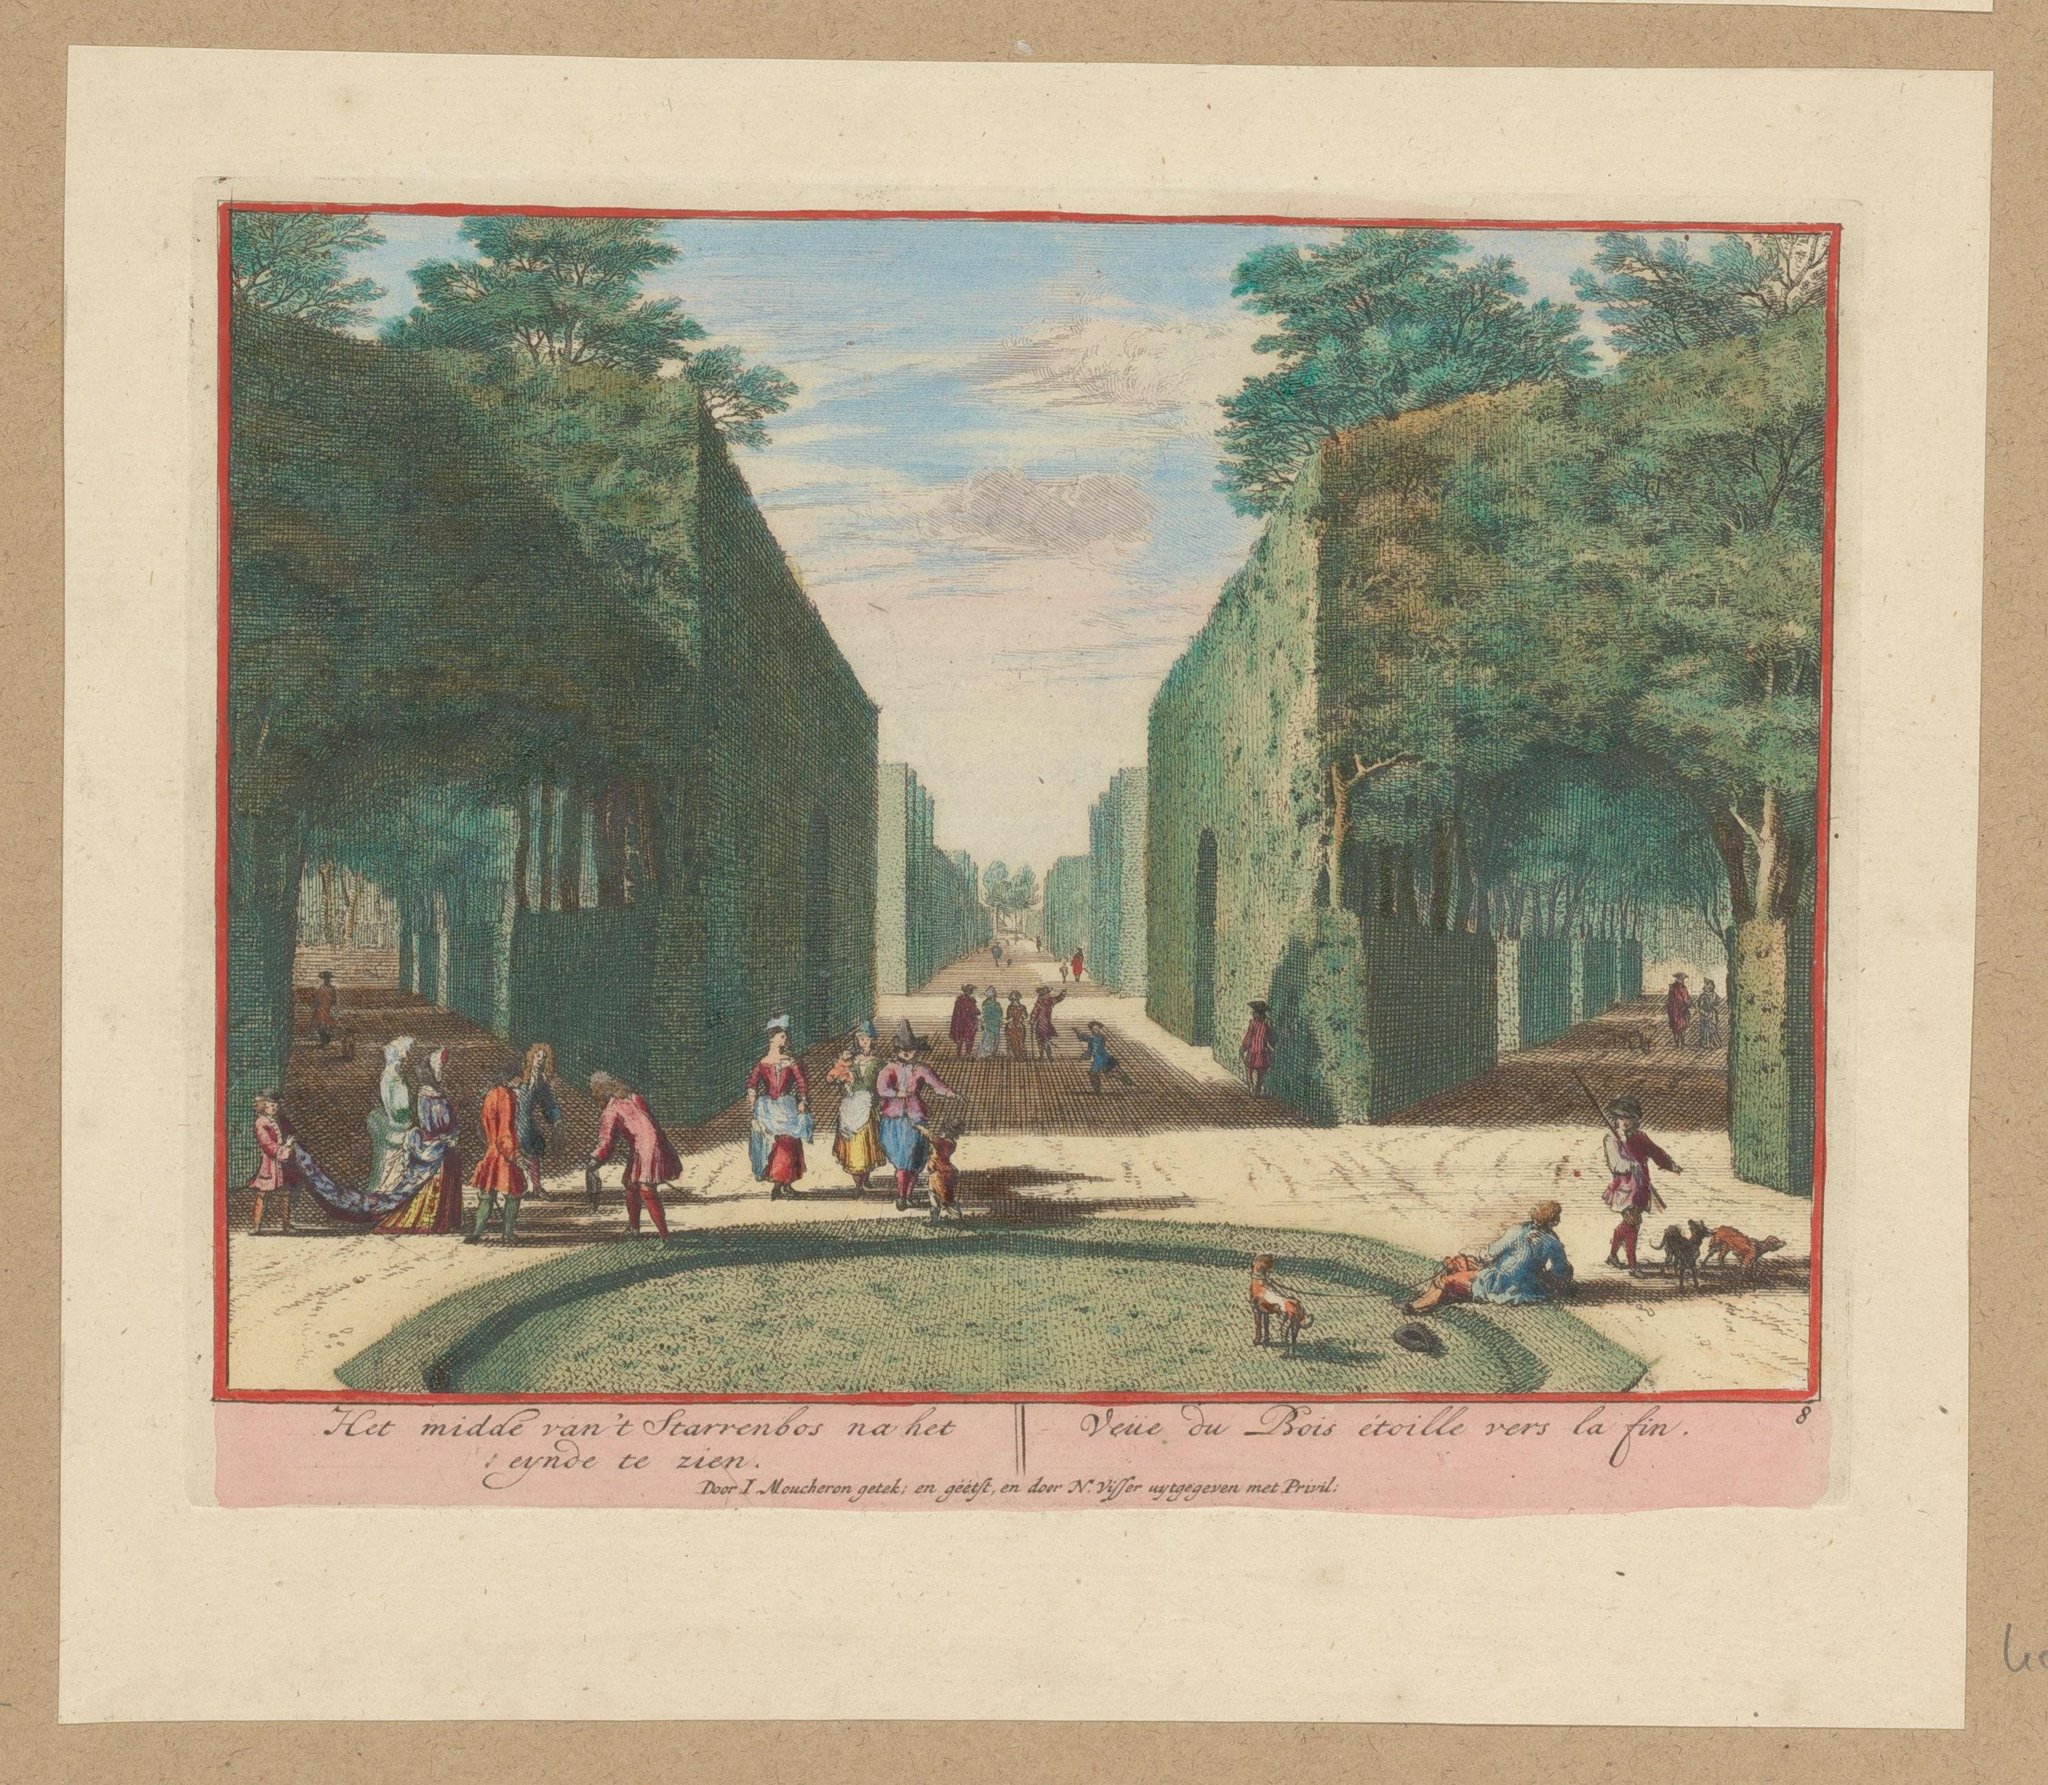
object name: print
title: Gezicht vanuit het midden van het Starrenbos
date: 1706-1719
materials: paper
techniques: engraving, etching, hand coloring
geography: amsterdam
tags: walking, hiking (recreation), french or architectonic garden; formal garden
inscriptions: stamp, collector's mark: Lugt 1641, stamp, stamp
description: Het midden van het zogeheten Starrenbos met verschillende wandelaars. Rechtsonder genummerd: 7. Onderwerpsrubrieken binnen de Atlas Zeden en Gewoonten: Zeden en Gewoonten in Engeren Zin, De Woning, Oude Nederlandsche Tuinkunst, De 17de en 18de eeuw. Stadtuinen.